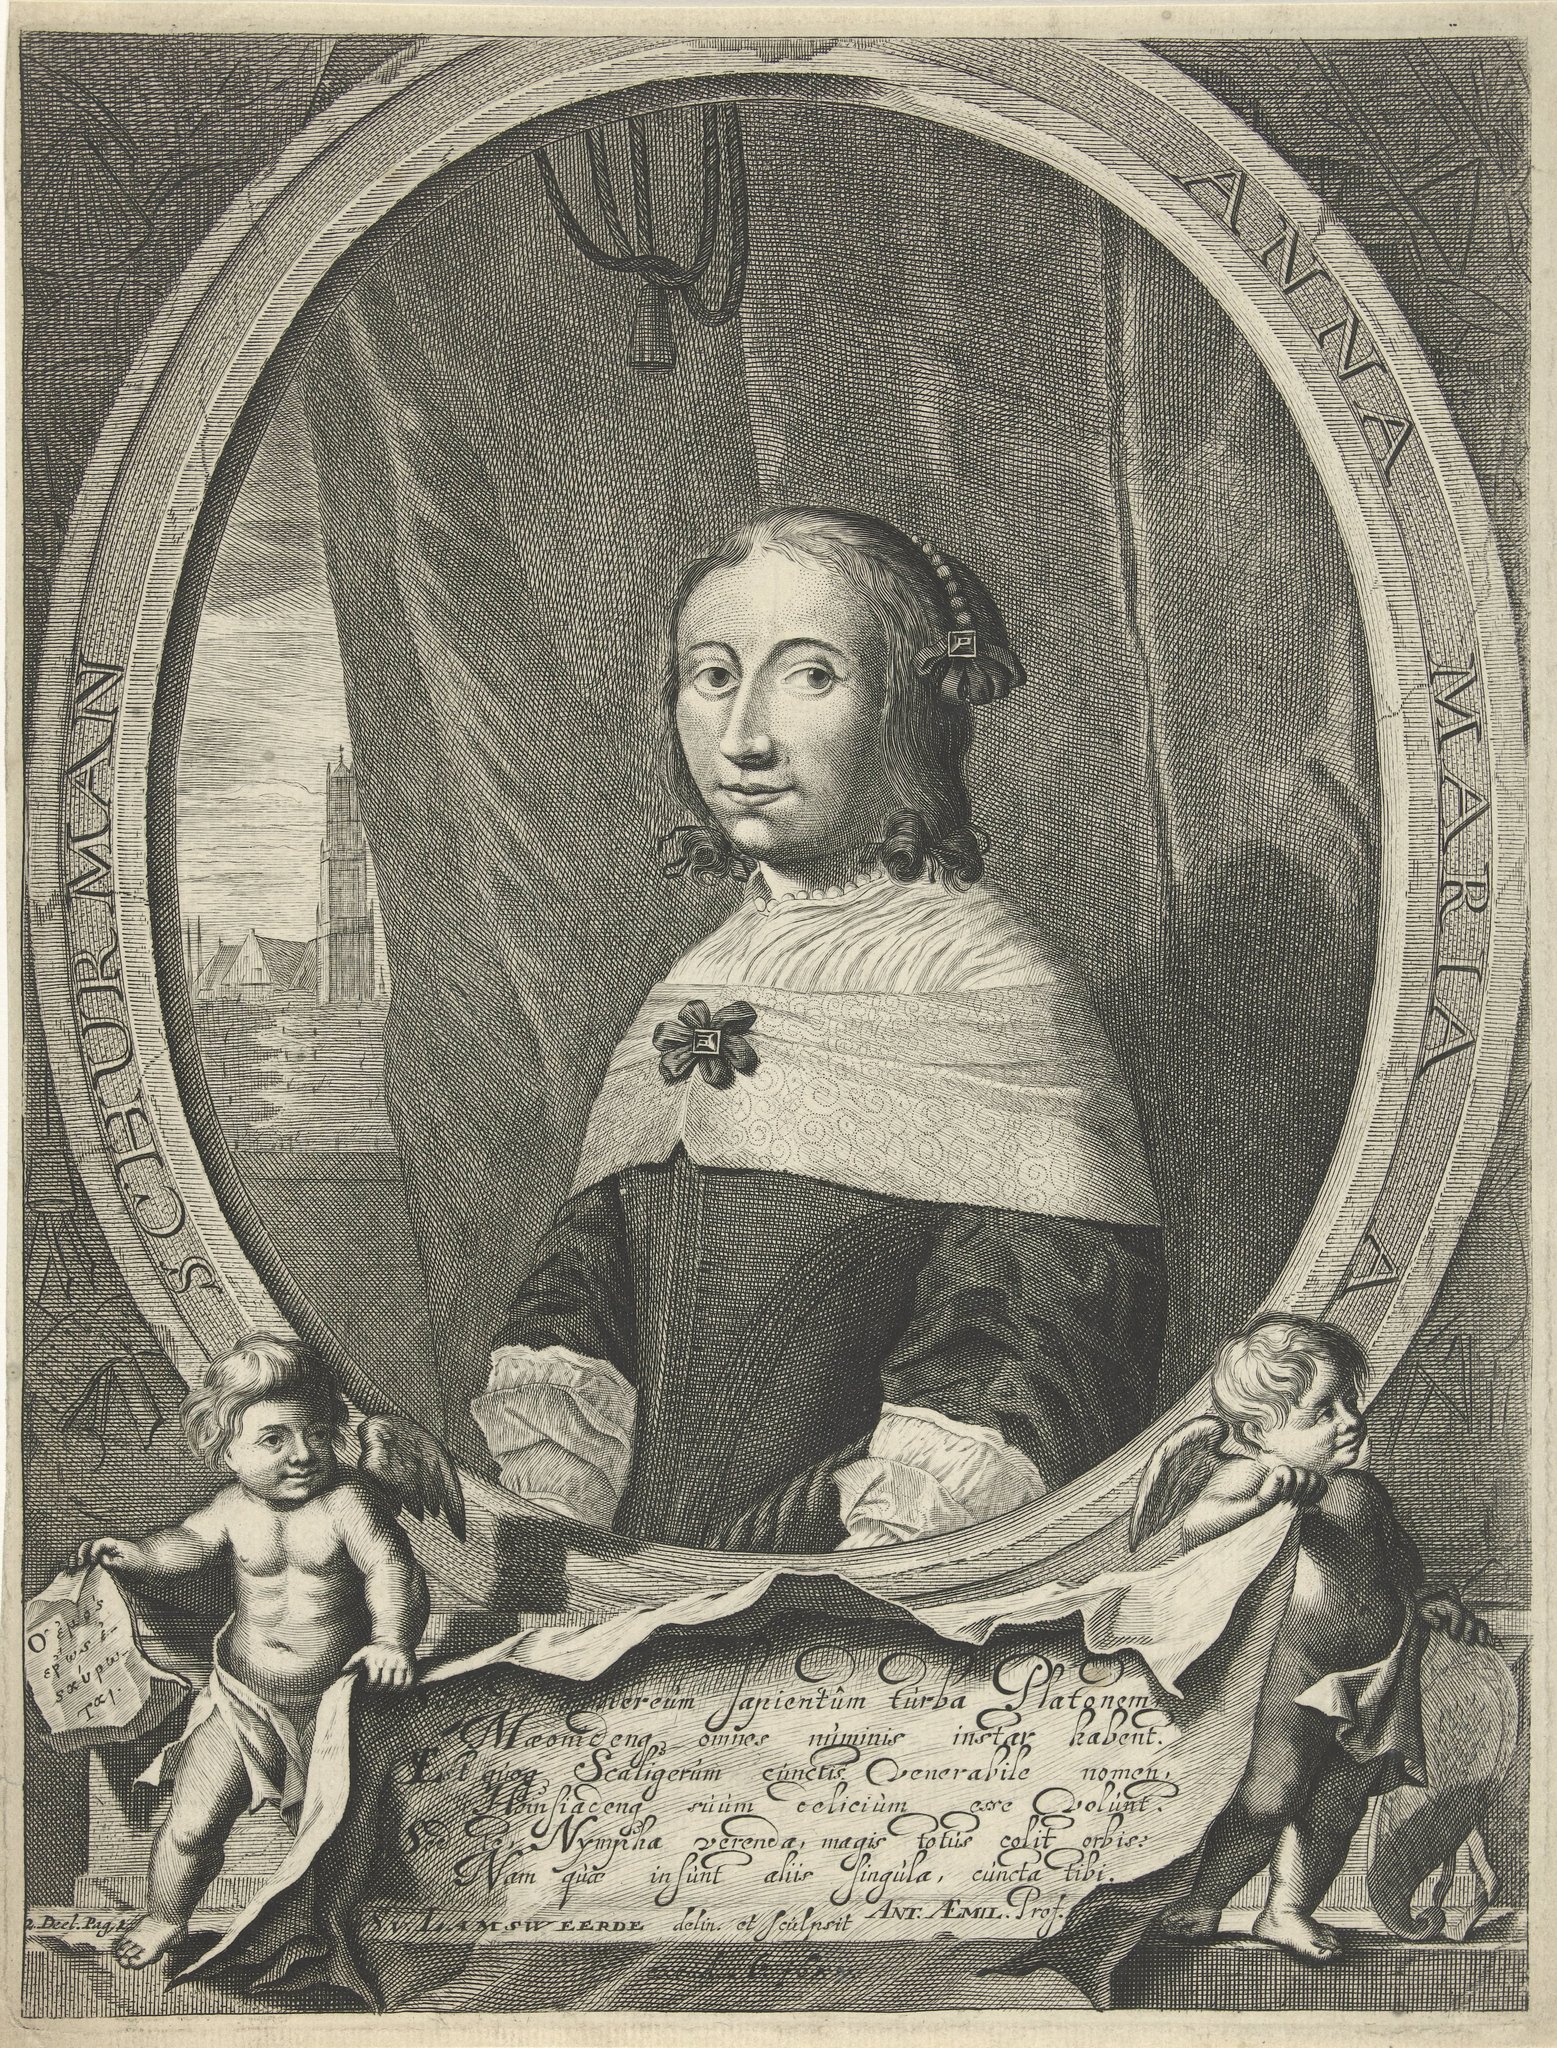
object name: print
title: Portret van Anna Maria van Schurman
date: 1657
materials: paper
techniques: engraving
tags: cologne, print maker, draughtsman, anna maria van schurman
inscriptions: collector's mark: Lugt 2228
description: Portretbuste in ovaal naar links van Anna Maria van Schurman, kunstenares en dichteres, blootshoofds. Links van de geportretteerde een gezicht op de Domtoren te Utrecht. Op de ovale omlijsting staat de naam van de geportretteerde, twee putti houden onder het portret een doek vast met een zesregelig Latijns vers.